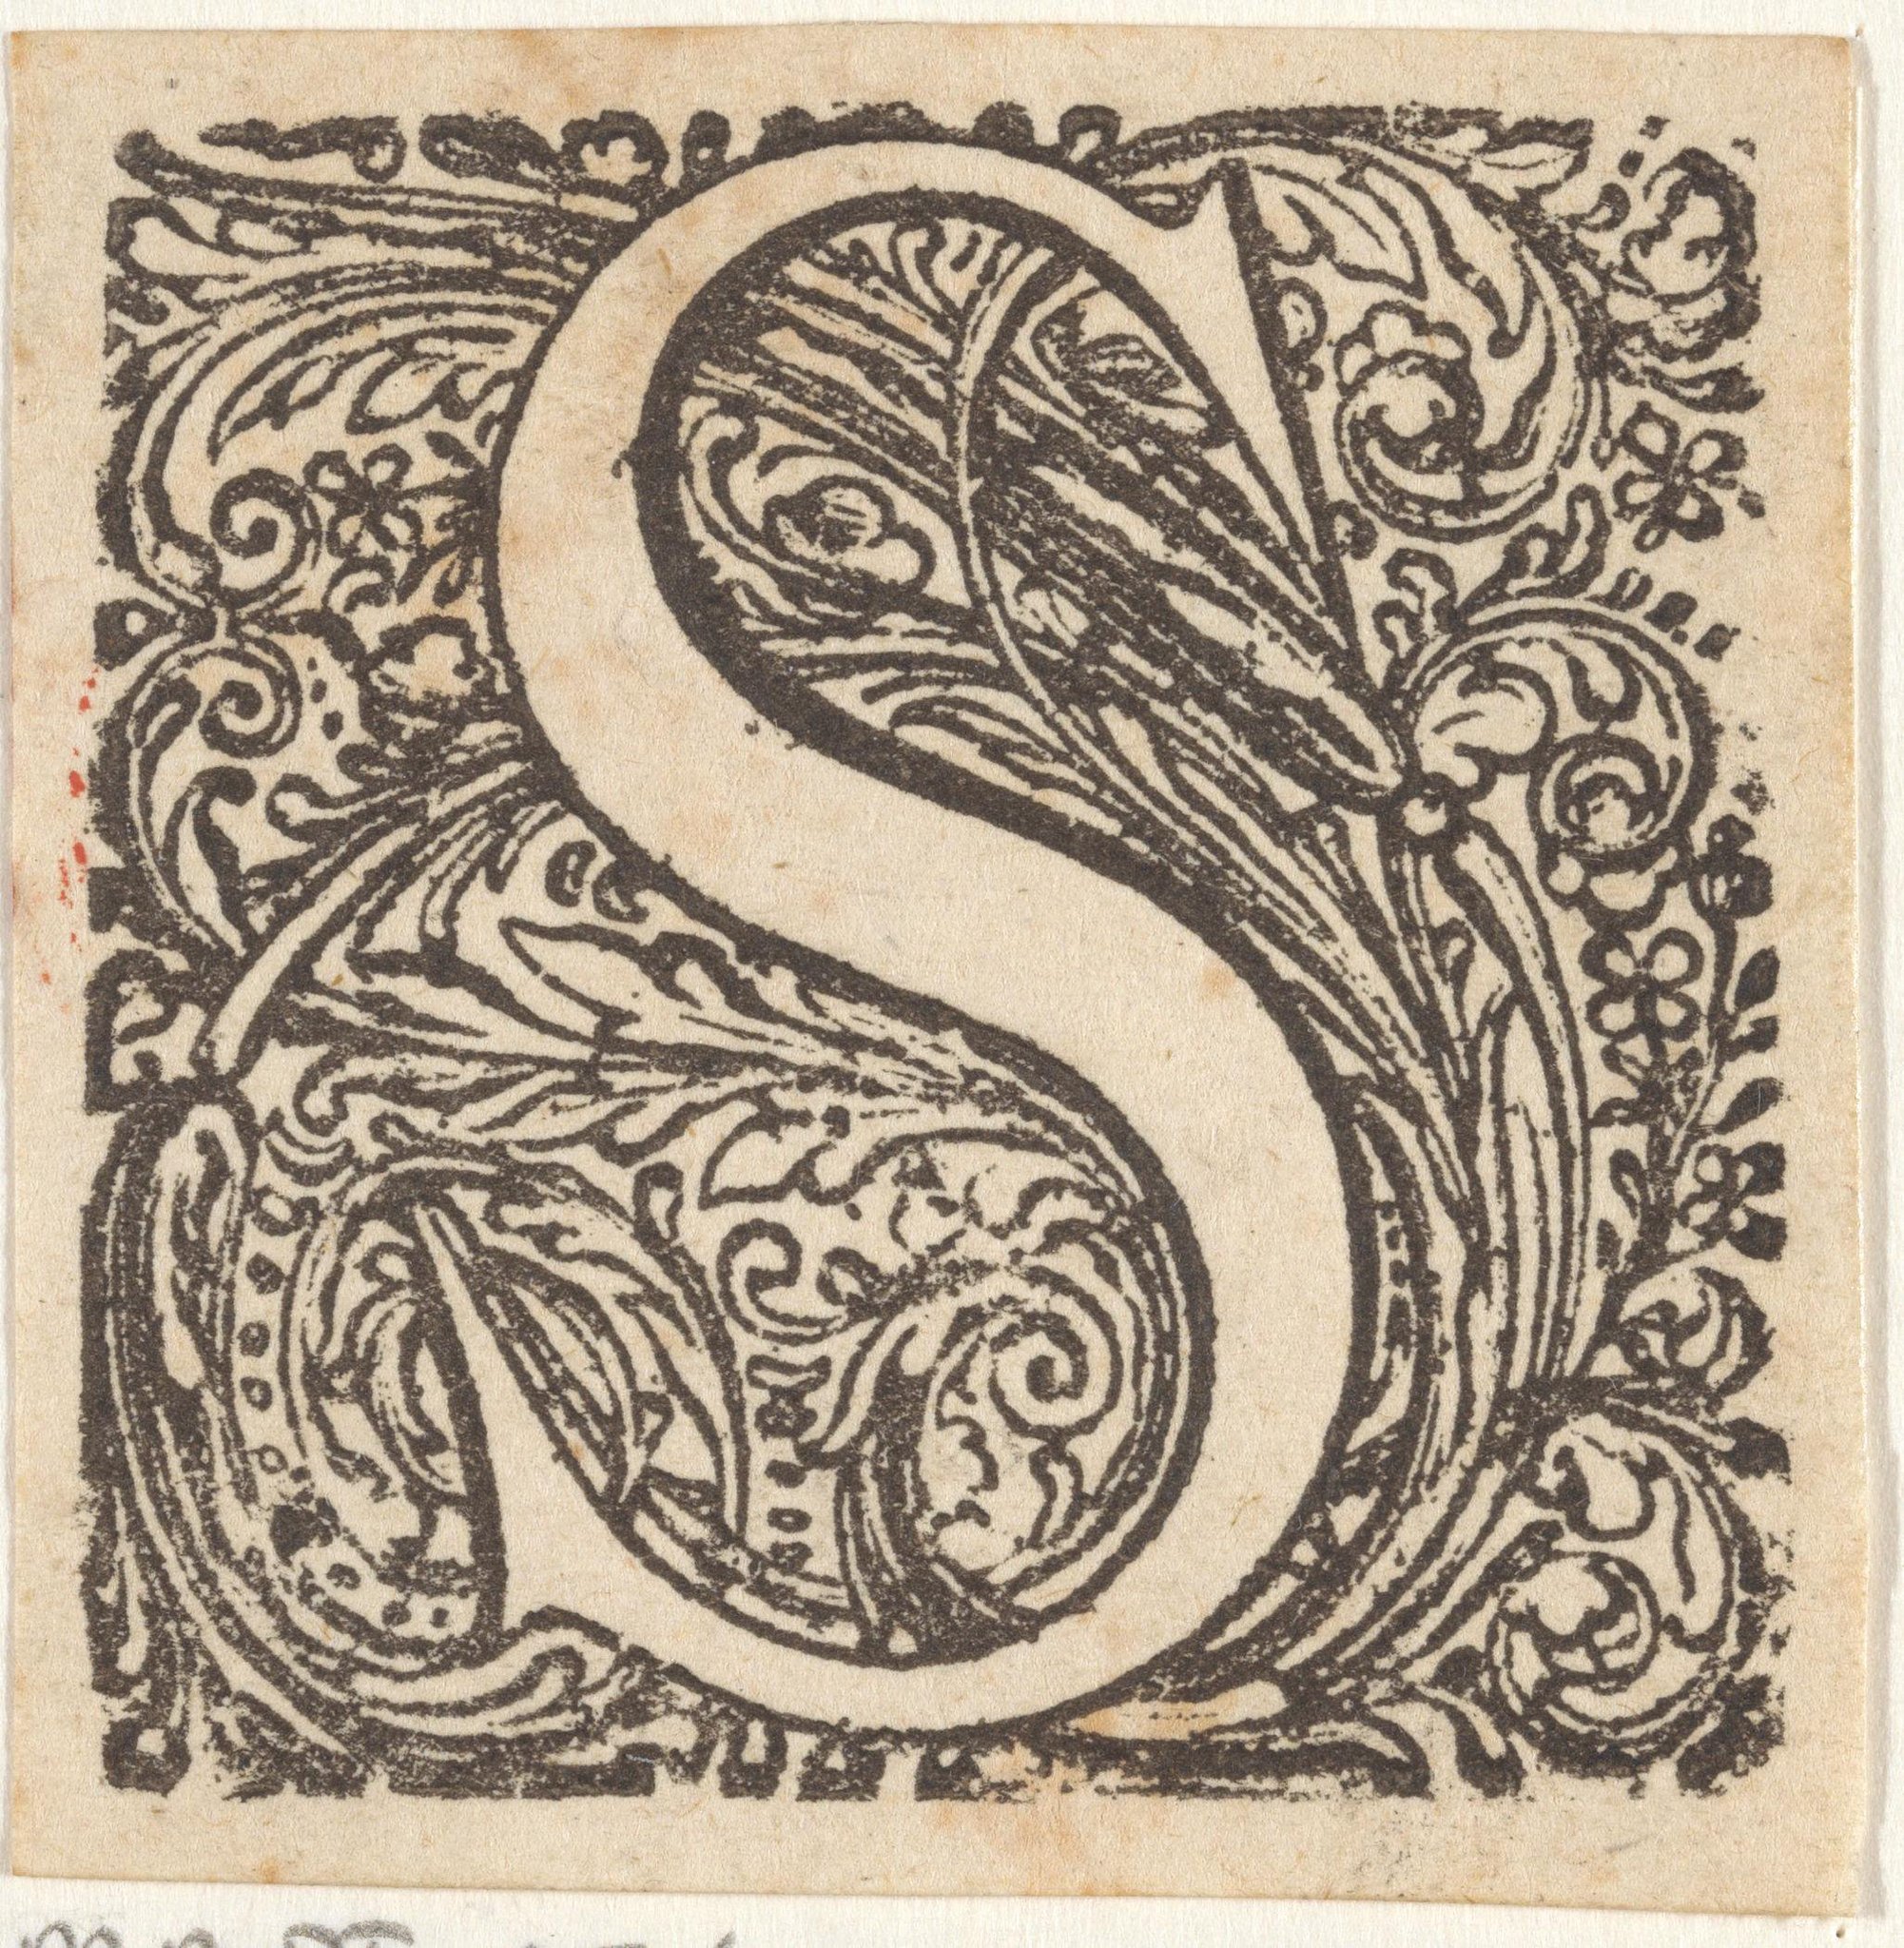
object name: print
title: Letter S in een geornamenteerde omlijsting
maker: Anonymous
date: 1600-1699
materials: paper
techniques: woodcut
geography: netherlands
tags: fancy letters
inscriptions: collector's mark: Lugt 240